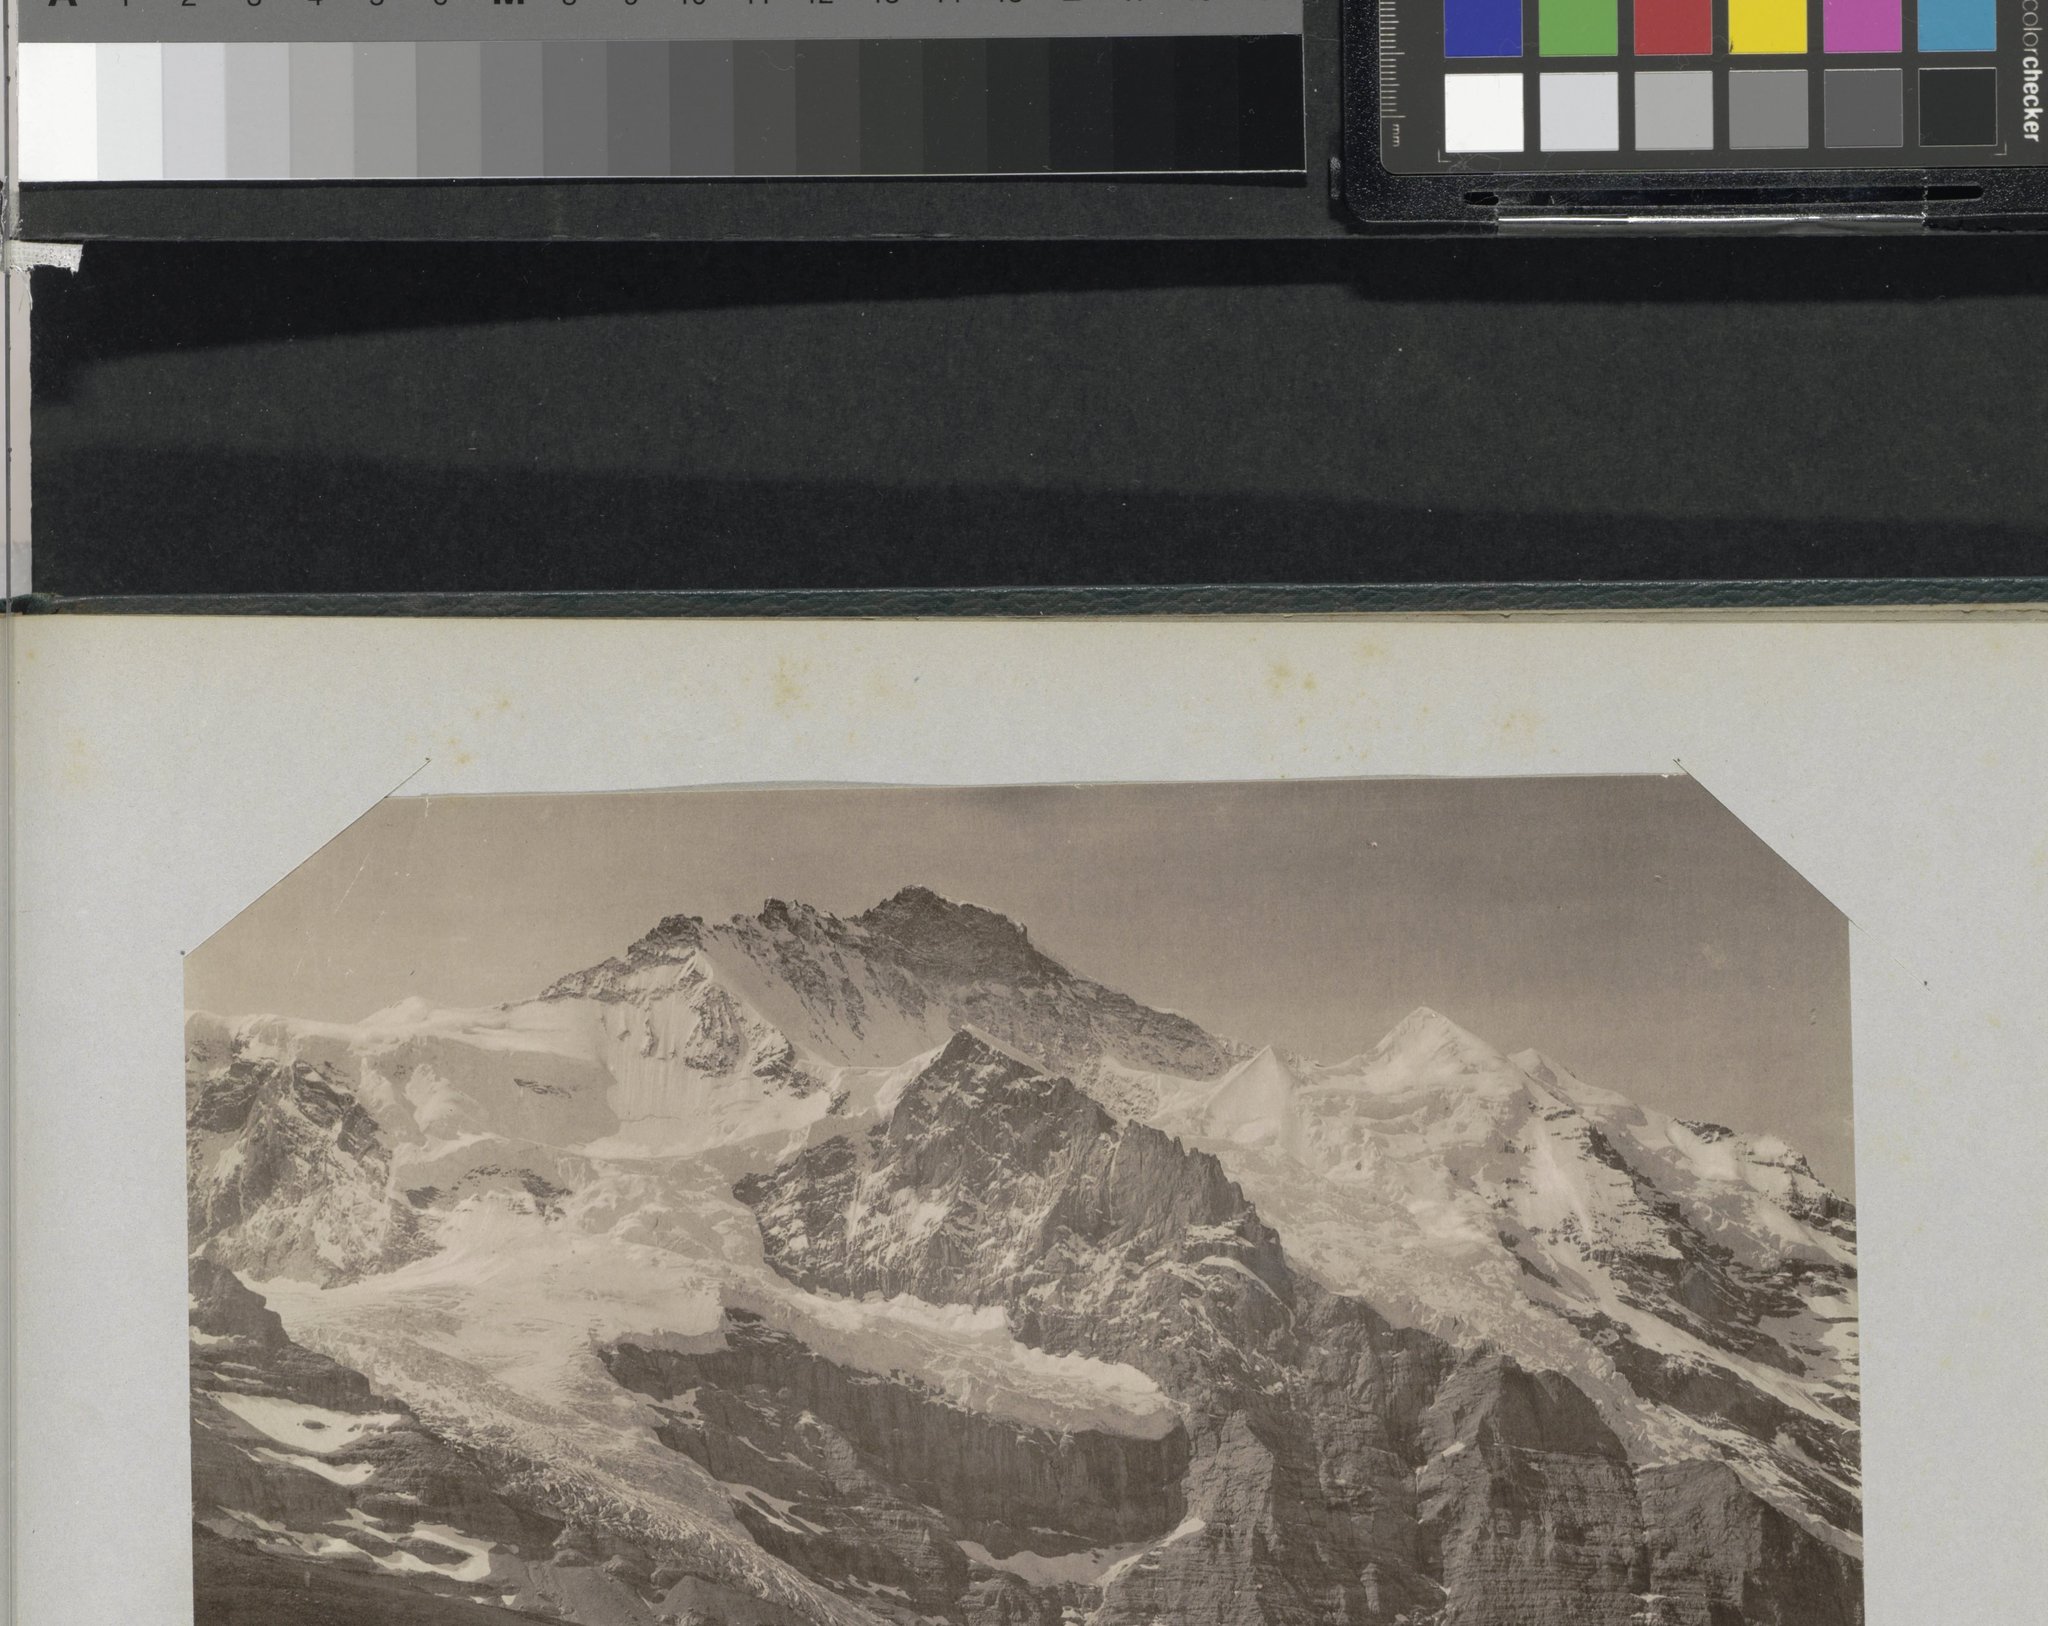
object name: album leaf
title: Gezicht op de Kleine Scheidegg en de Jungfrau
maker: Anonymous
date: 1896-1897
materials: paper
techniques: photograph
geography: zurich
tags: mountain-range, snow peaks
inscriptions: inscription: ‘Edit: Schröder & Co. Zürich./ No. 250 Petite Scheidegg (Jungfrau)’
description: Deze prent maakt deel uit van een album.